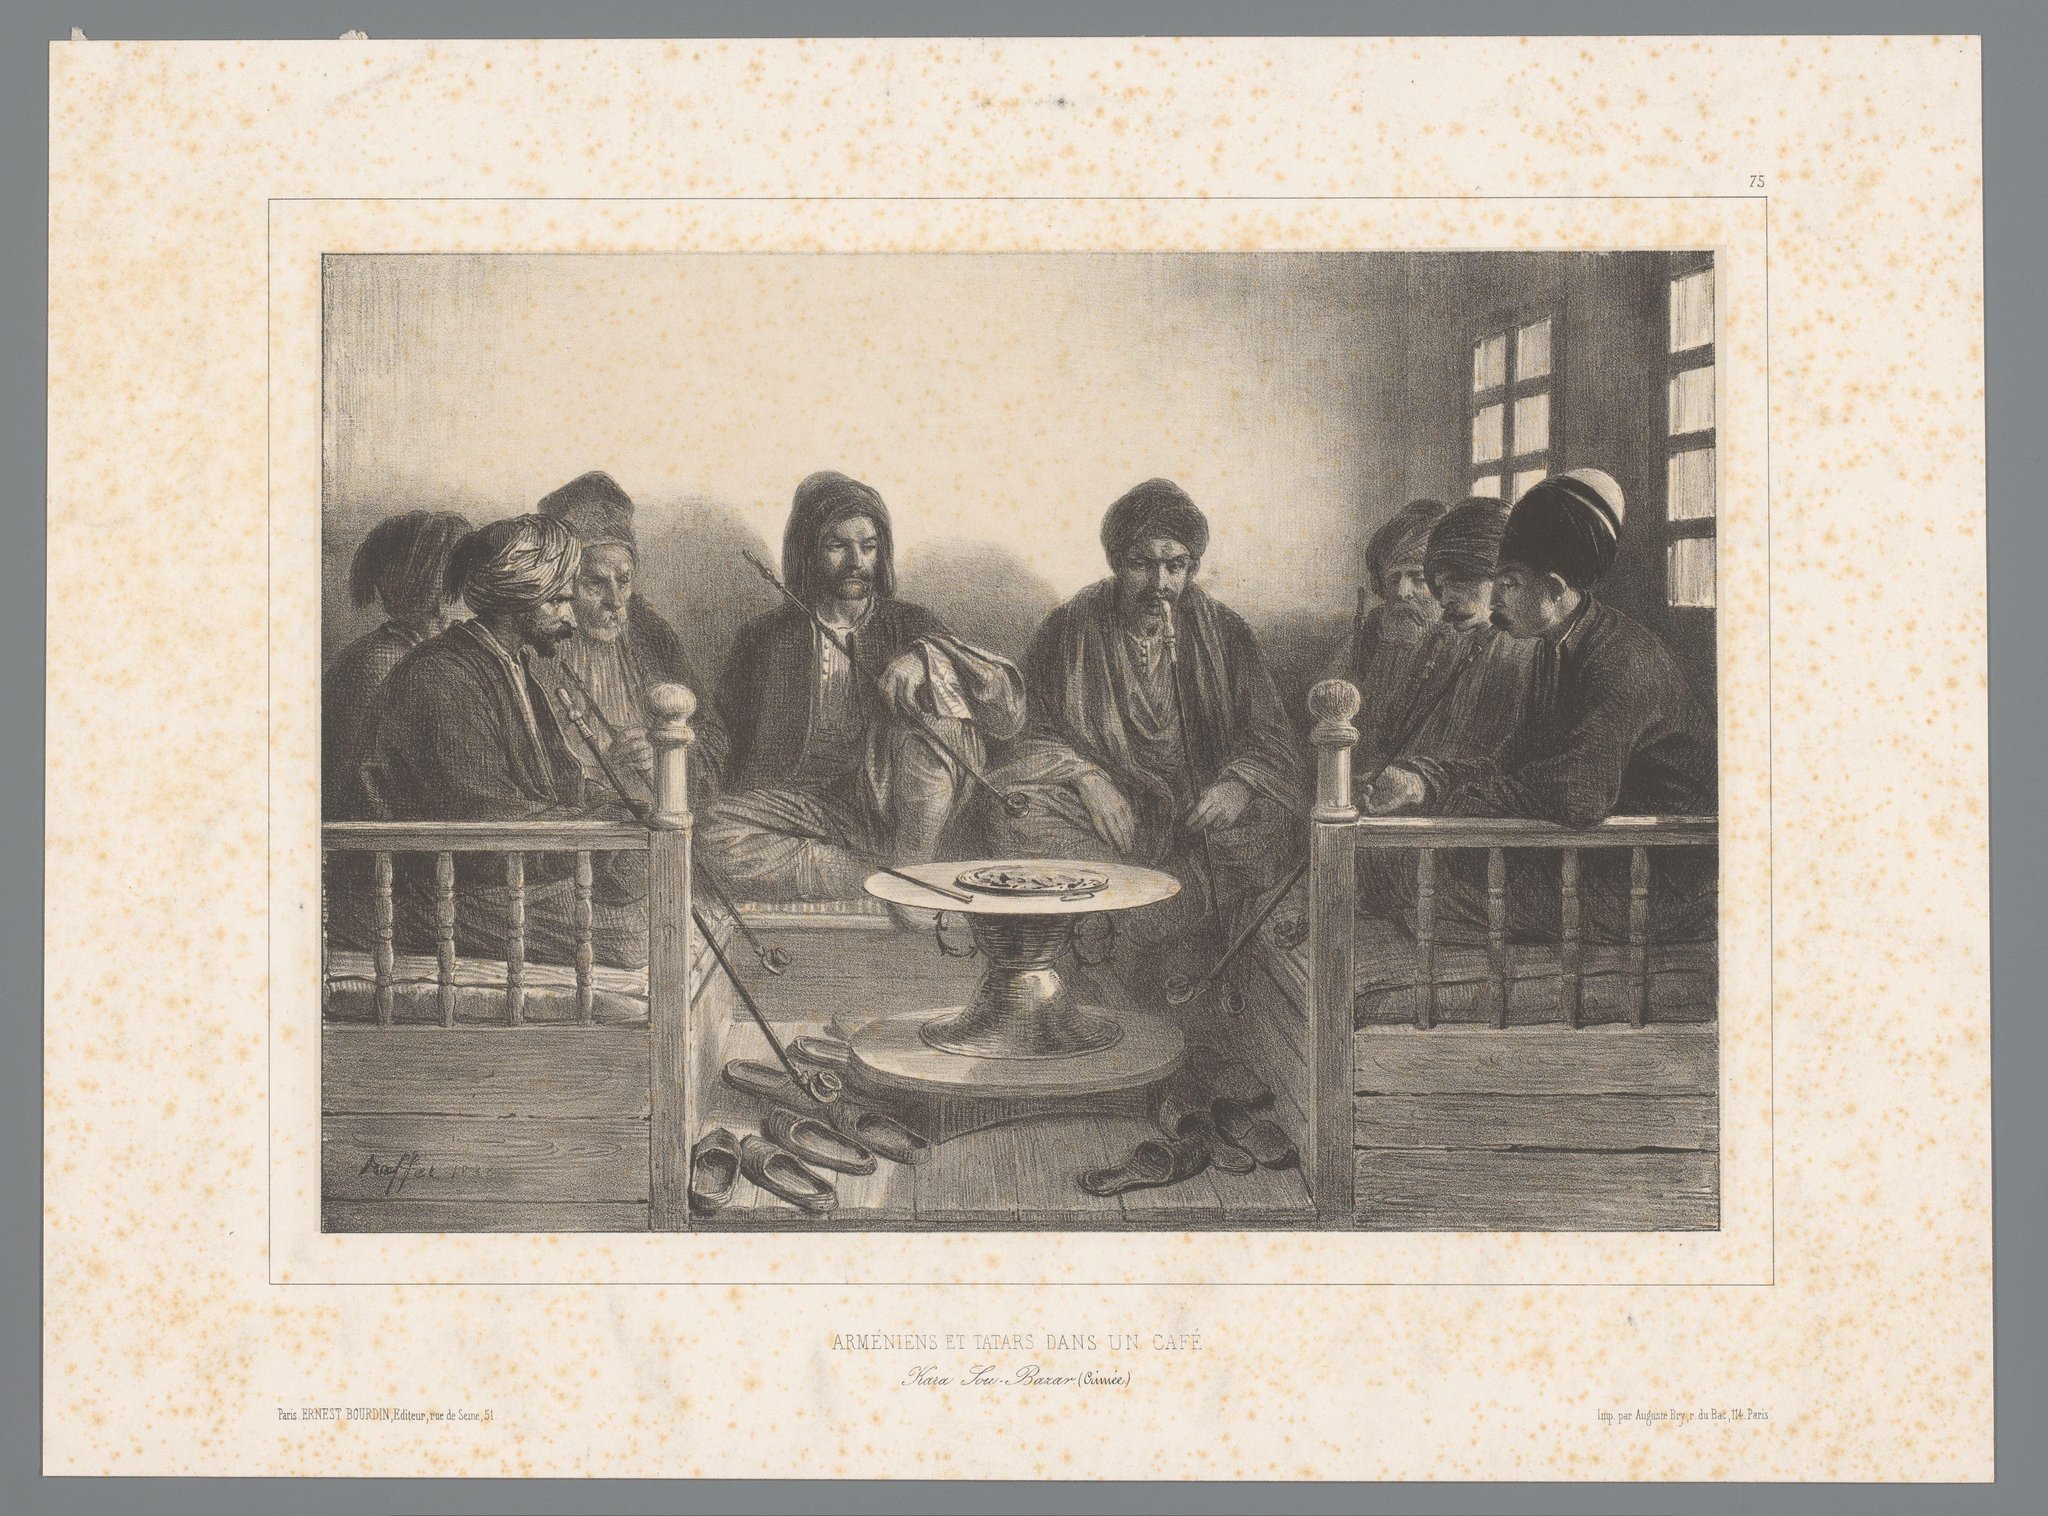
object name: print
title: Voyage dans la Russie Méridionale et la Crimée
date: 1838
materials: paper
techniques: lithograph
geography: paris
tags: fashion, clothing, adult man, pipe ~ tobacco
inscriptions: check stamp: ‘Ernest Bourdin éditeur’, collector's mark: Lugt 2228